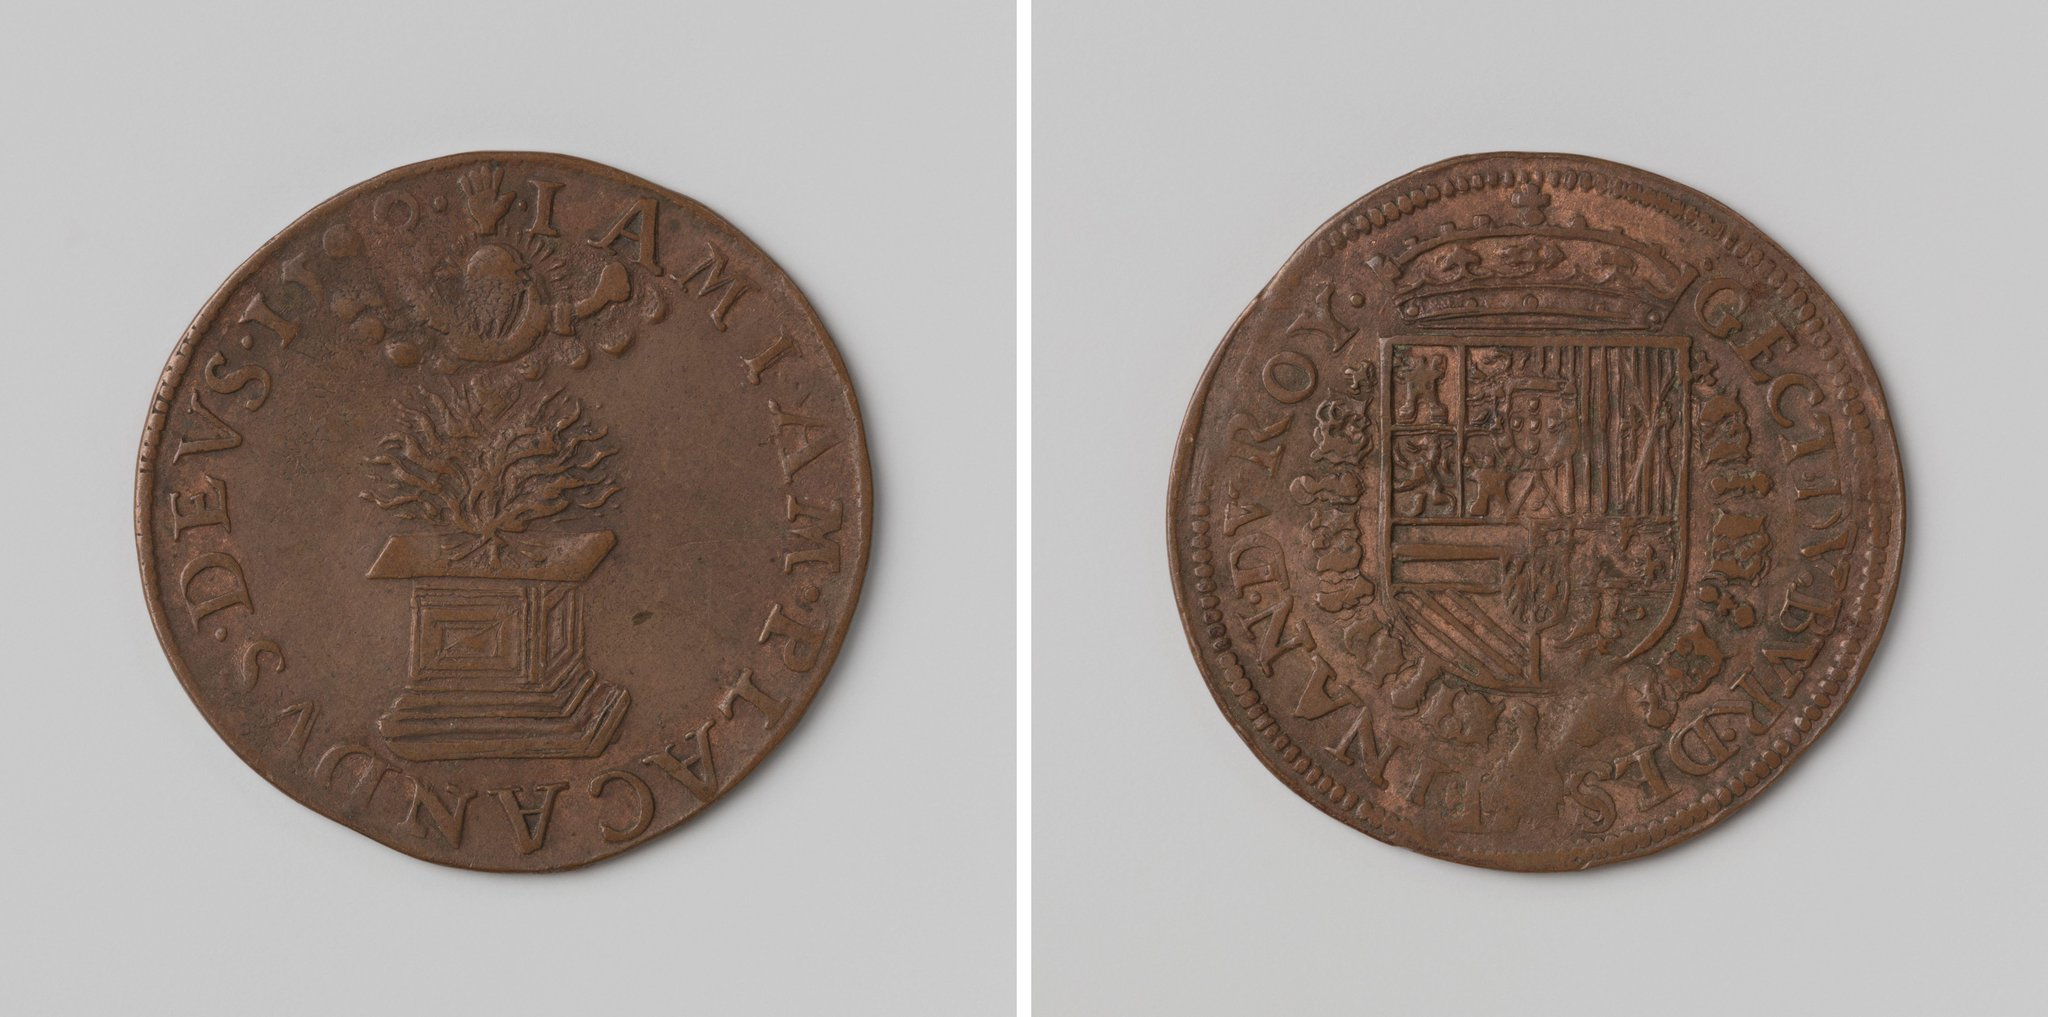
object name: jeton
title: Allegorische voorstelling, rekenpenning van de raad van Financiën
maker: Anonymous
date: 1590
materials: copper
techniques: striking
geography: antwerp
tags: philip ii of spain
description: Koperen penning. Voorzijde: hart boven een brandend altaar; daarboven God, verschijnend in wolken binnen omschrift. Keerzijde: gekroond wapenschild, omhangen met de orde van het Gulden Vlies binnen omschrift